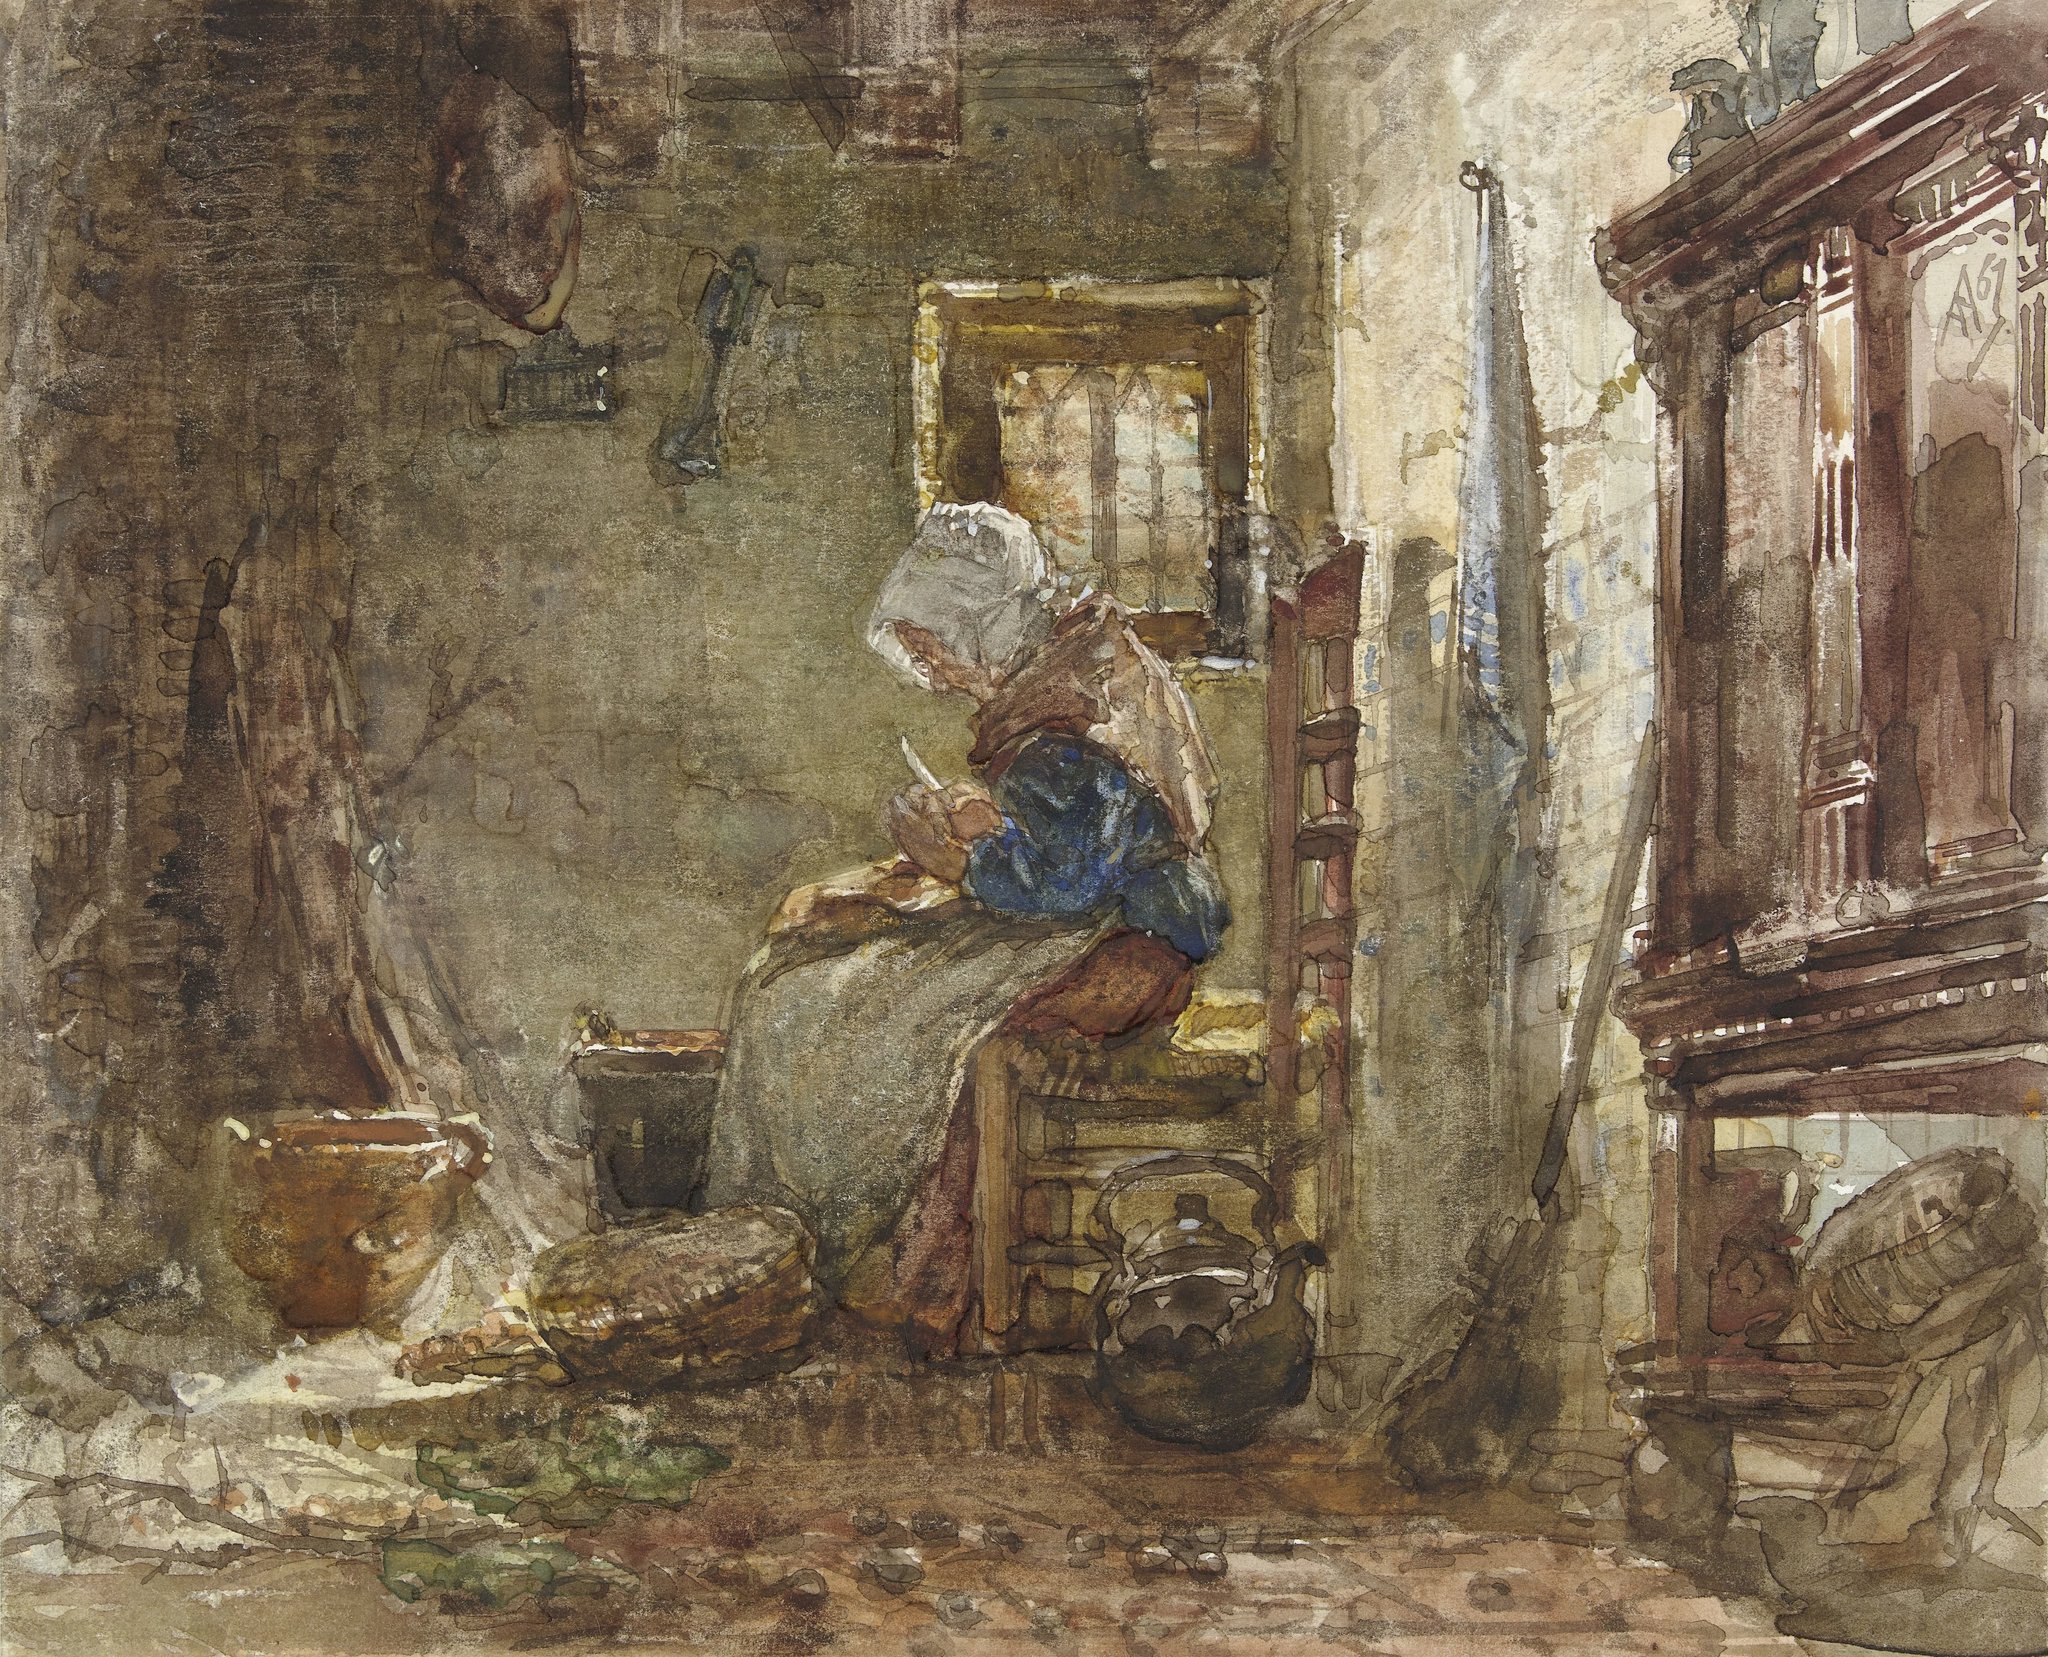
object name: drawing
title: Aardappelschilster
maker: august allebé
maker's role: draughtsman, print maker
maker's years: 1838-1927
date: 1867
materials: paper, pencil, watercolor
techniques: brush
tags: cleaning vegetables